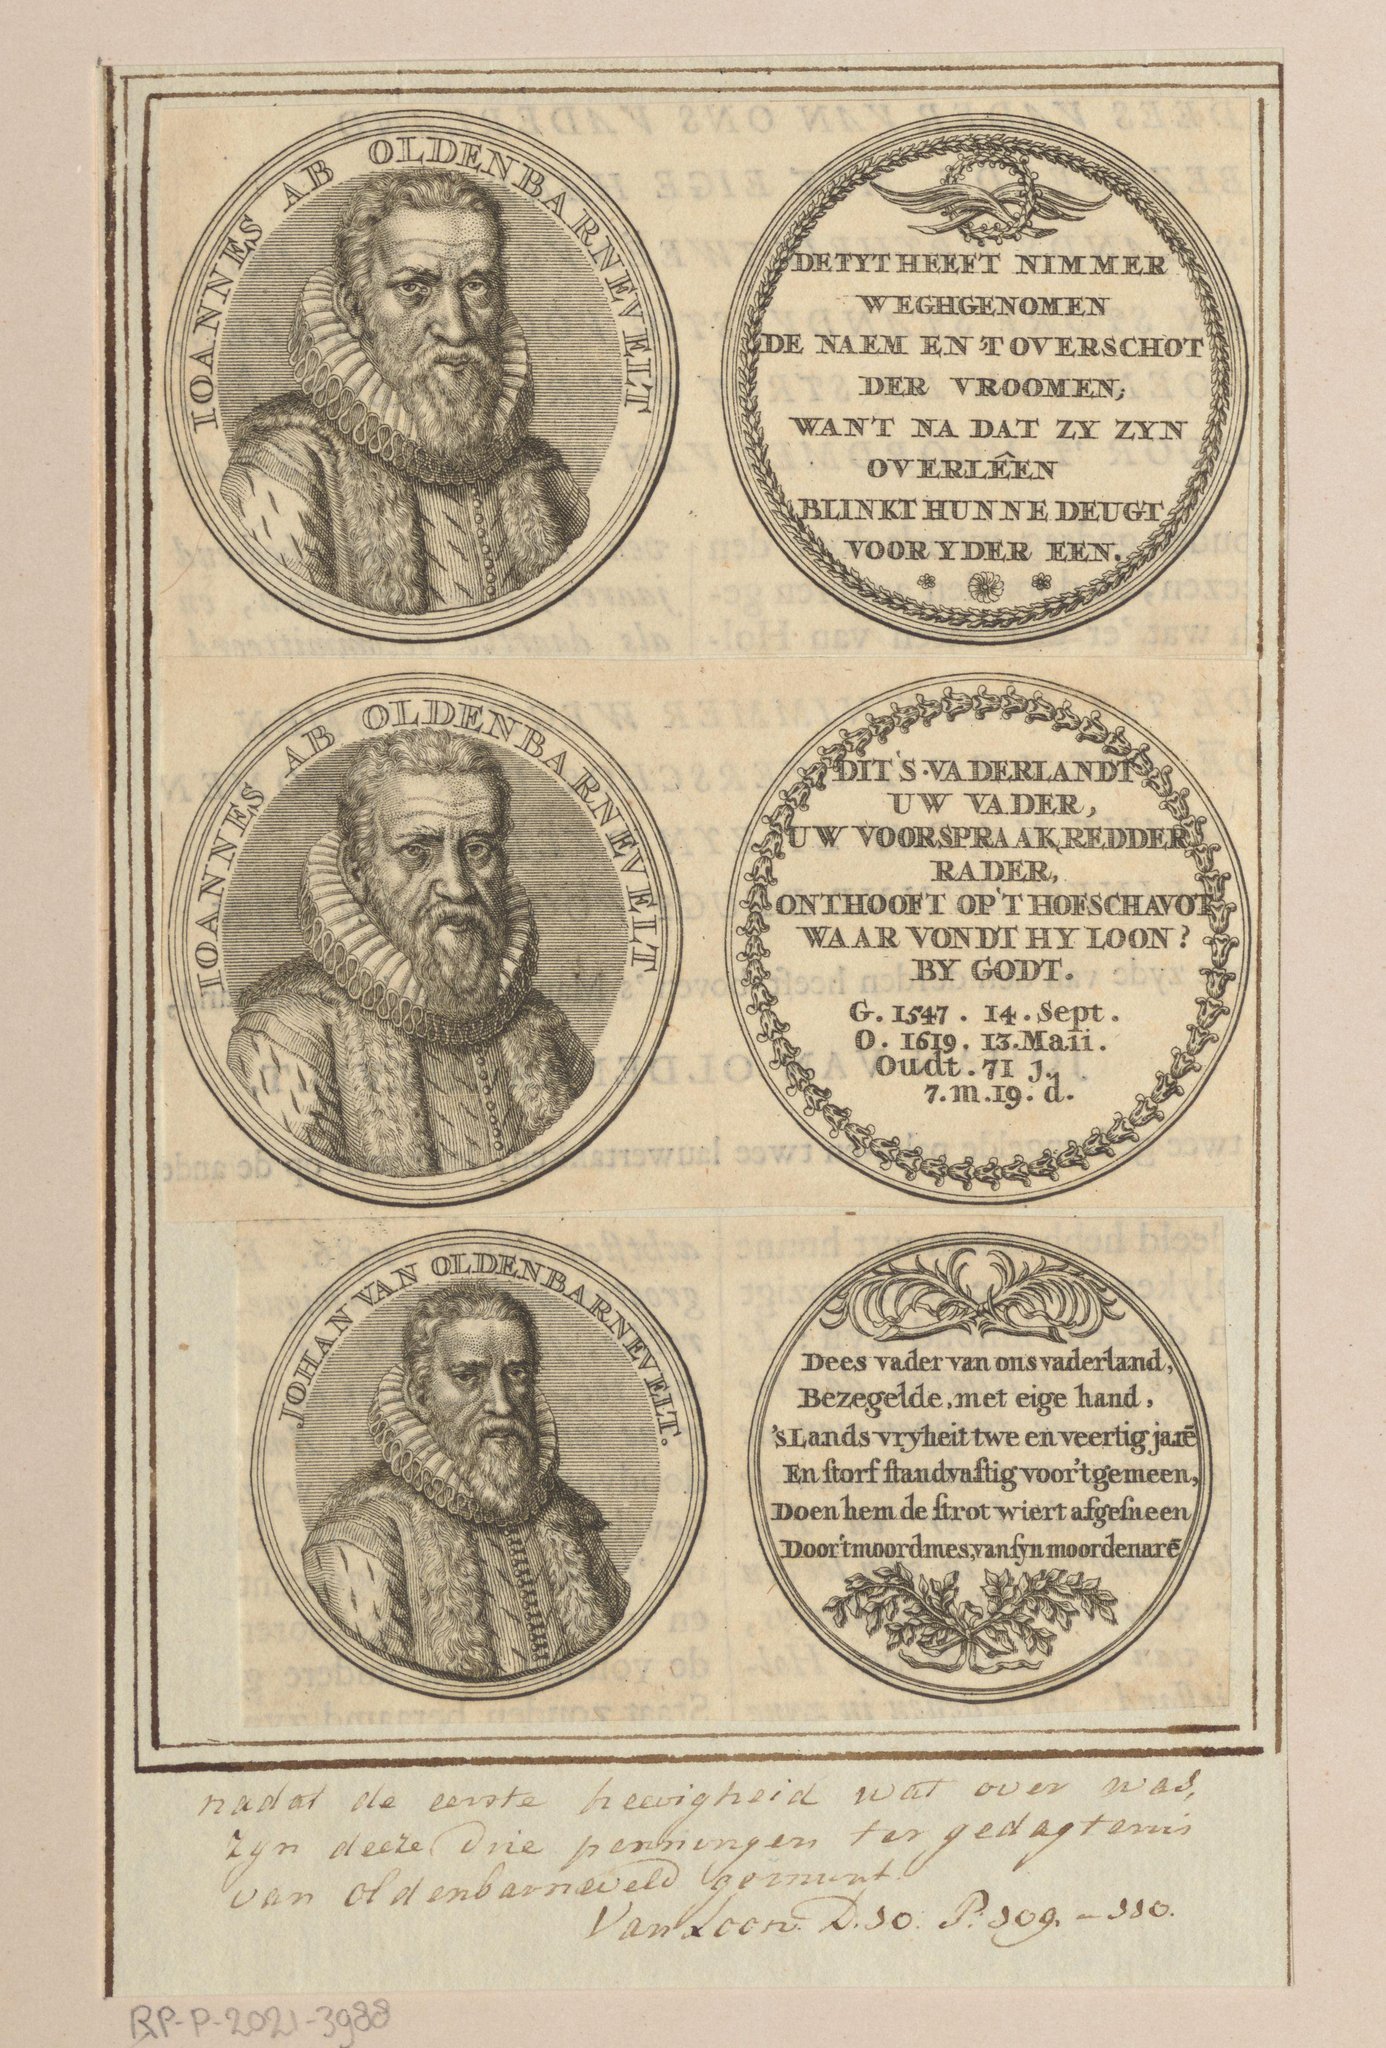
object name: book illustration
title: Drie penningen met het portret van Johan van Oldenbarnevelt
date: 1726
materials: paper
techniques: etching, letterpress printing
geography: the hague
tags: the hague, johan van oldenbarnevelt, historical persons, coin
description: Prent uit: Loon, Gerard van. Beschryving der Nederlandsche historipenningen. Den Haag: Christiaan van Lom, Pieter Gosse en Pieter de Hondt, 1726, dl. 2, p. 109.